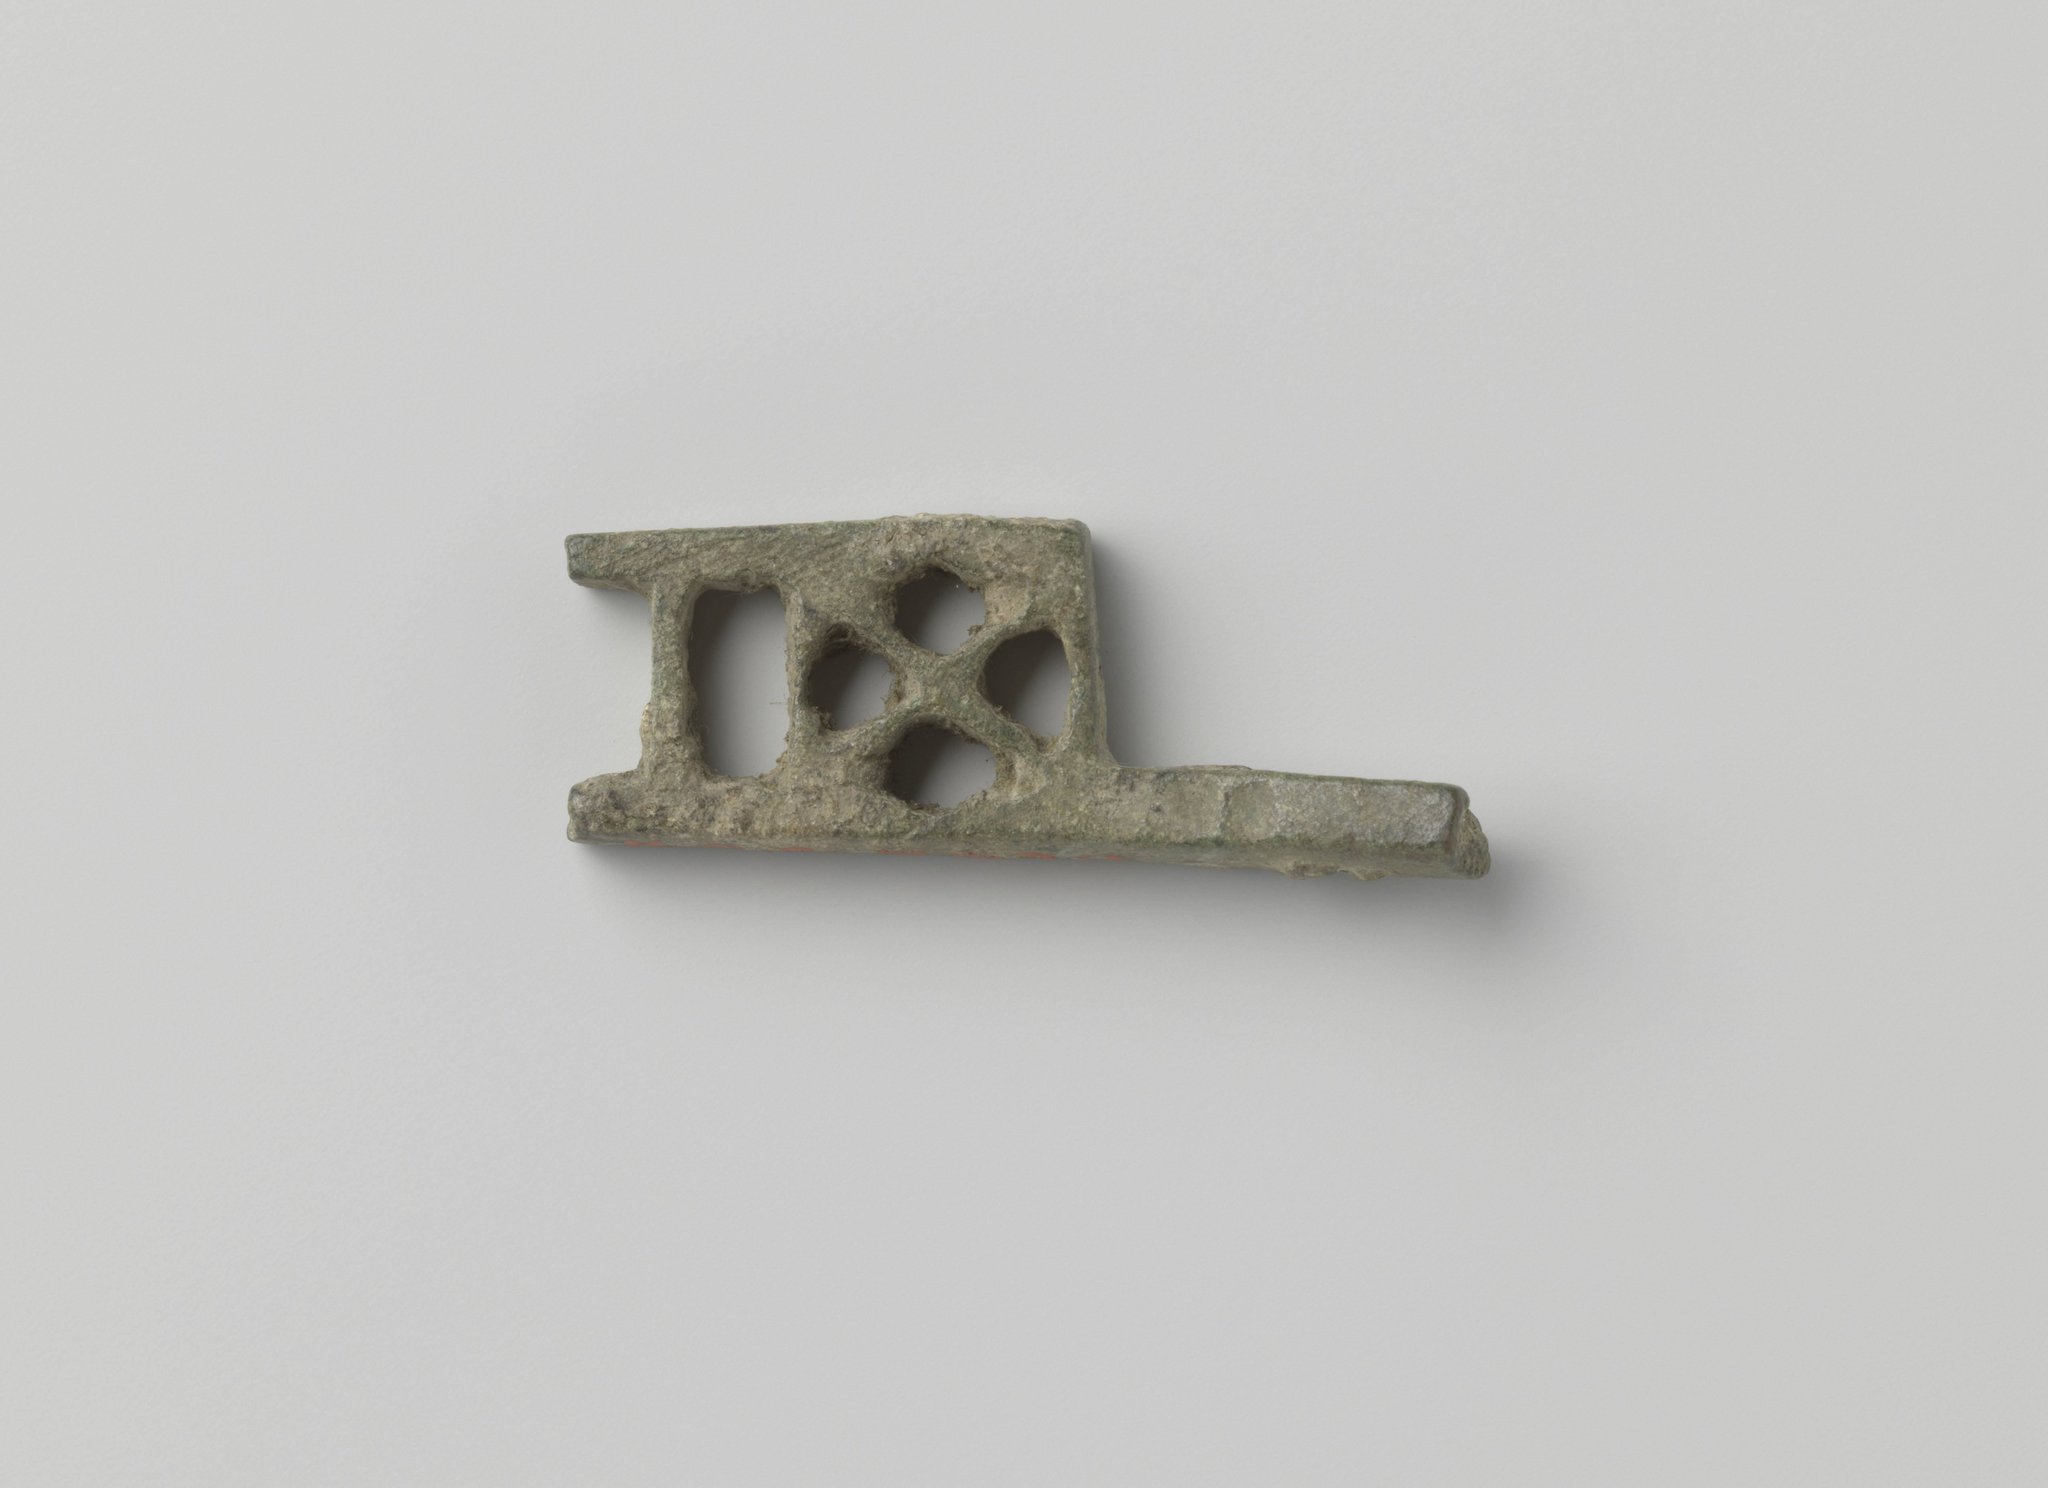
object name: lock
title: Fragment van schot en slot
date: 1400-1950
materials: bronze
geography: rome